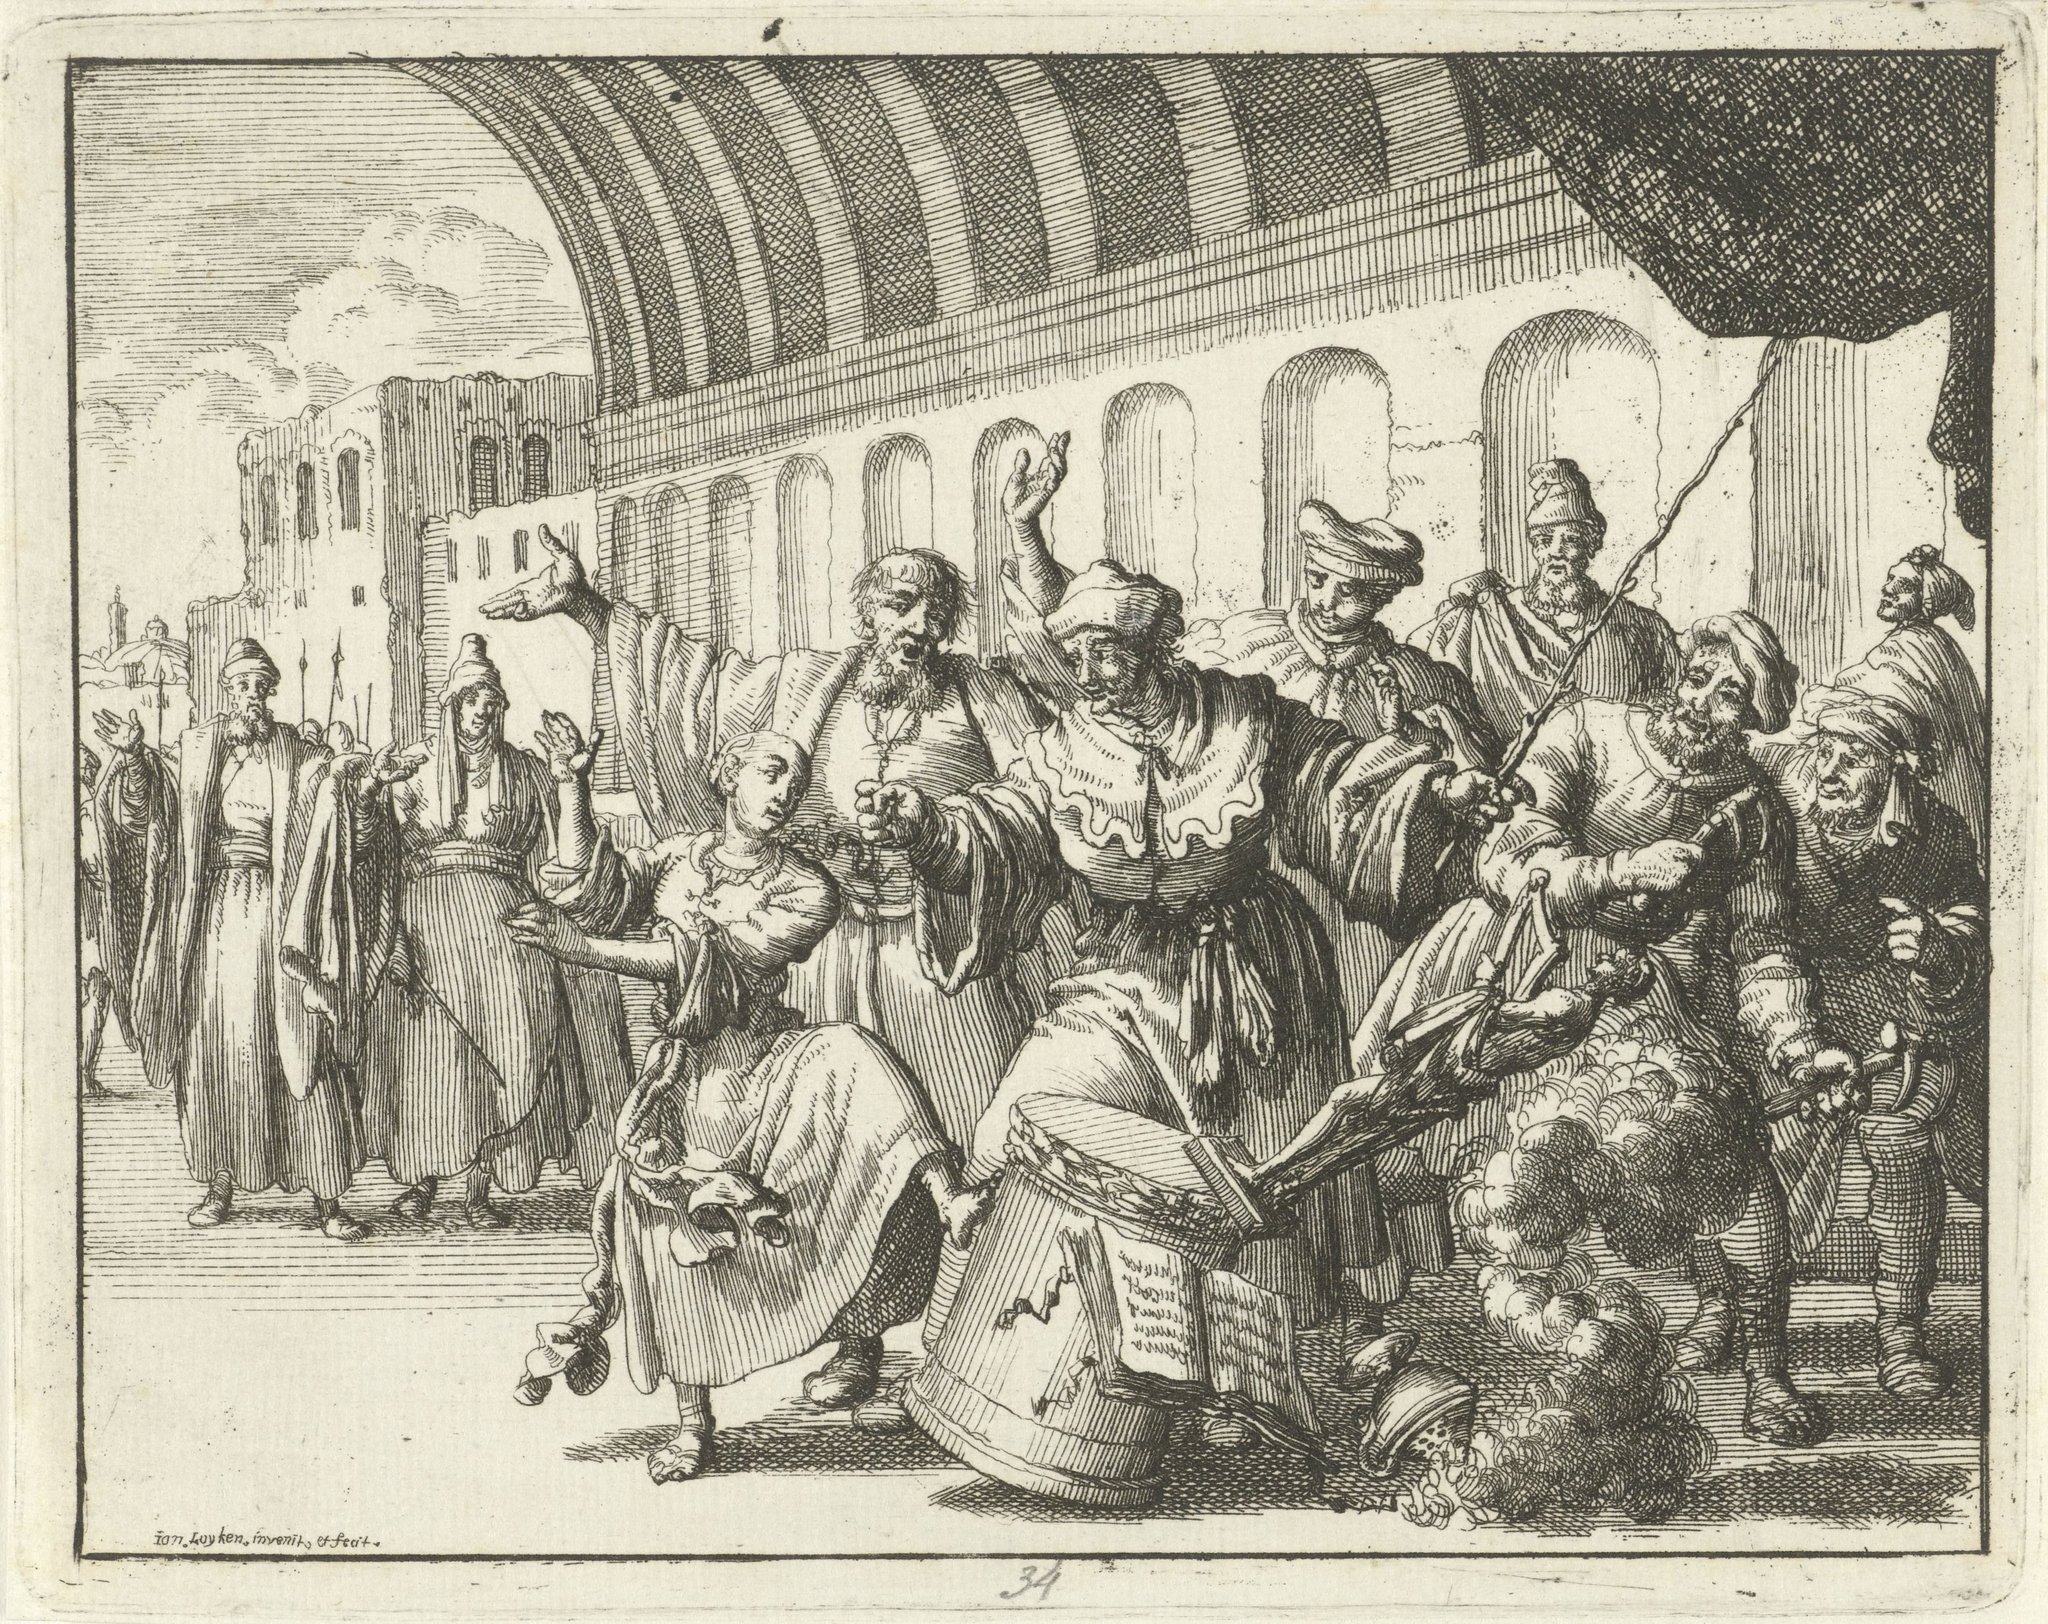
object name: book illustration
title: Eulalia van Mérida schopt een heidens altaar om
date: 1685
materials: paper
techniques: etching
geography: amsterdam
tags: altar ~ non-christian religions, female saints (with name)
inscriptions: number: ‘34’, collector's mark: Lugt 2228